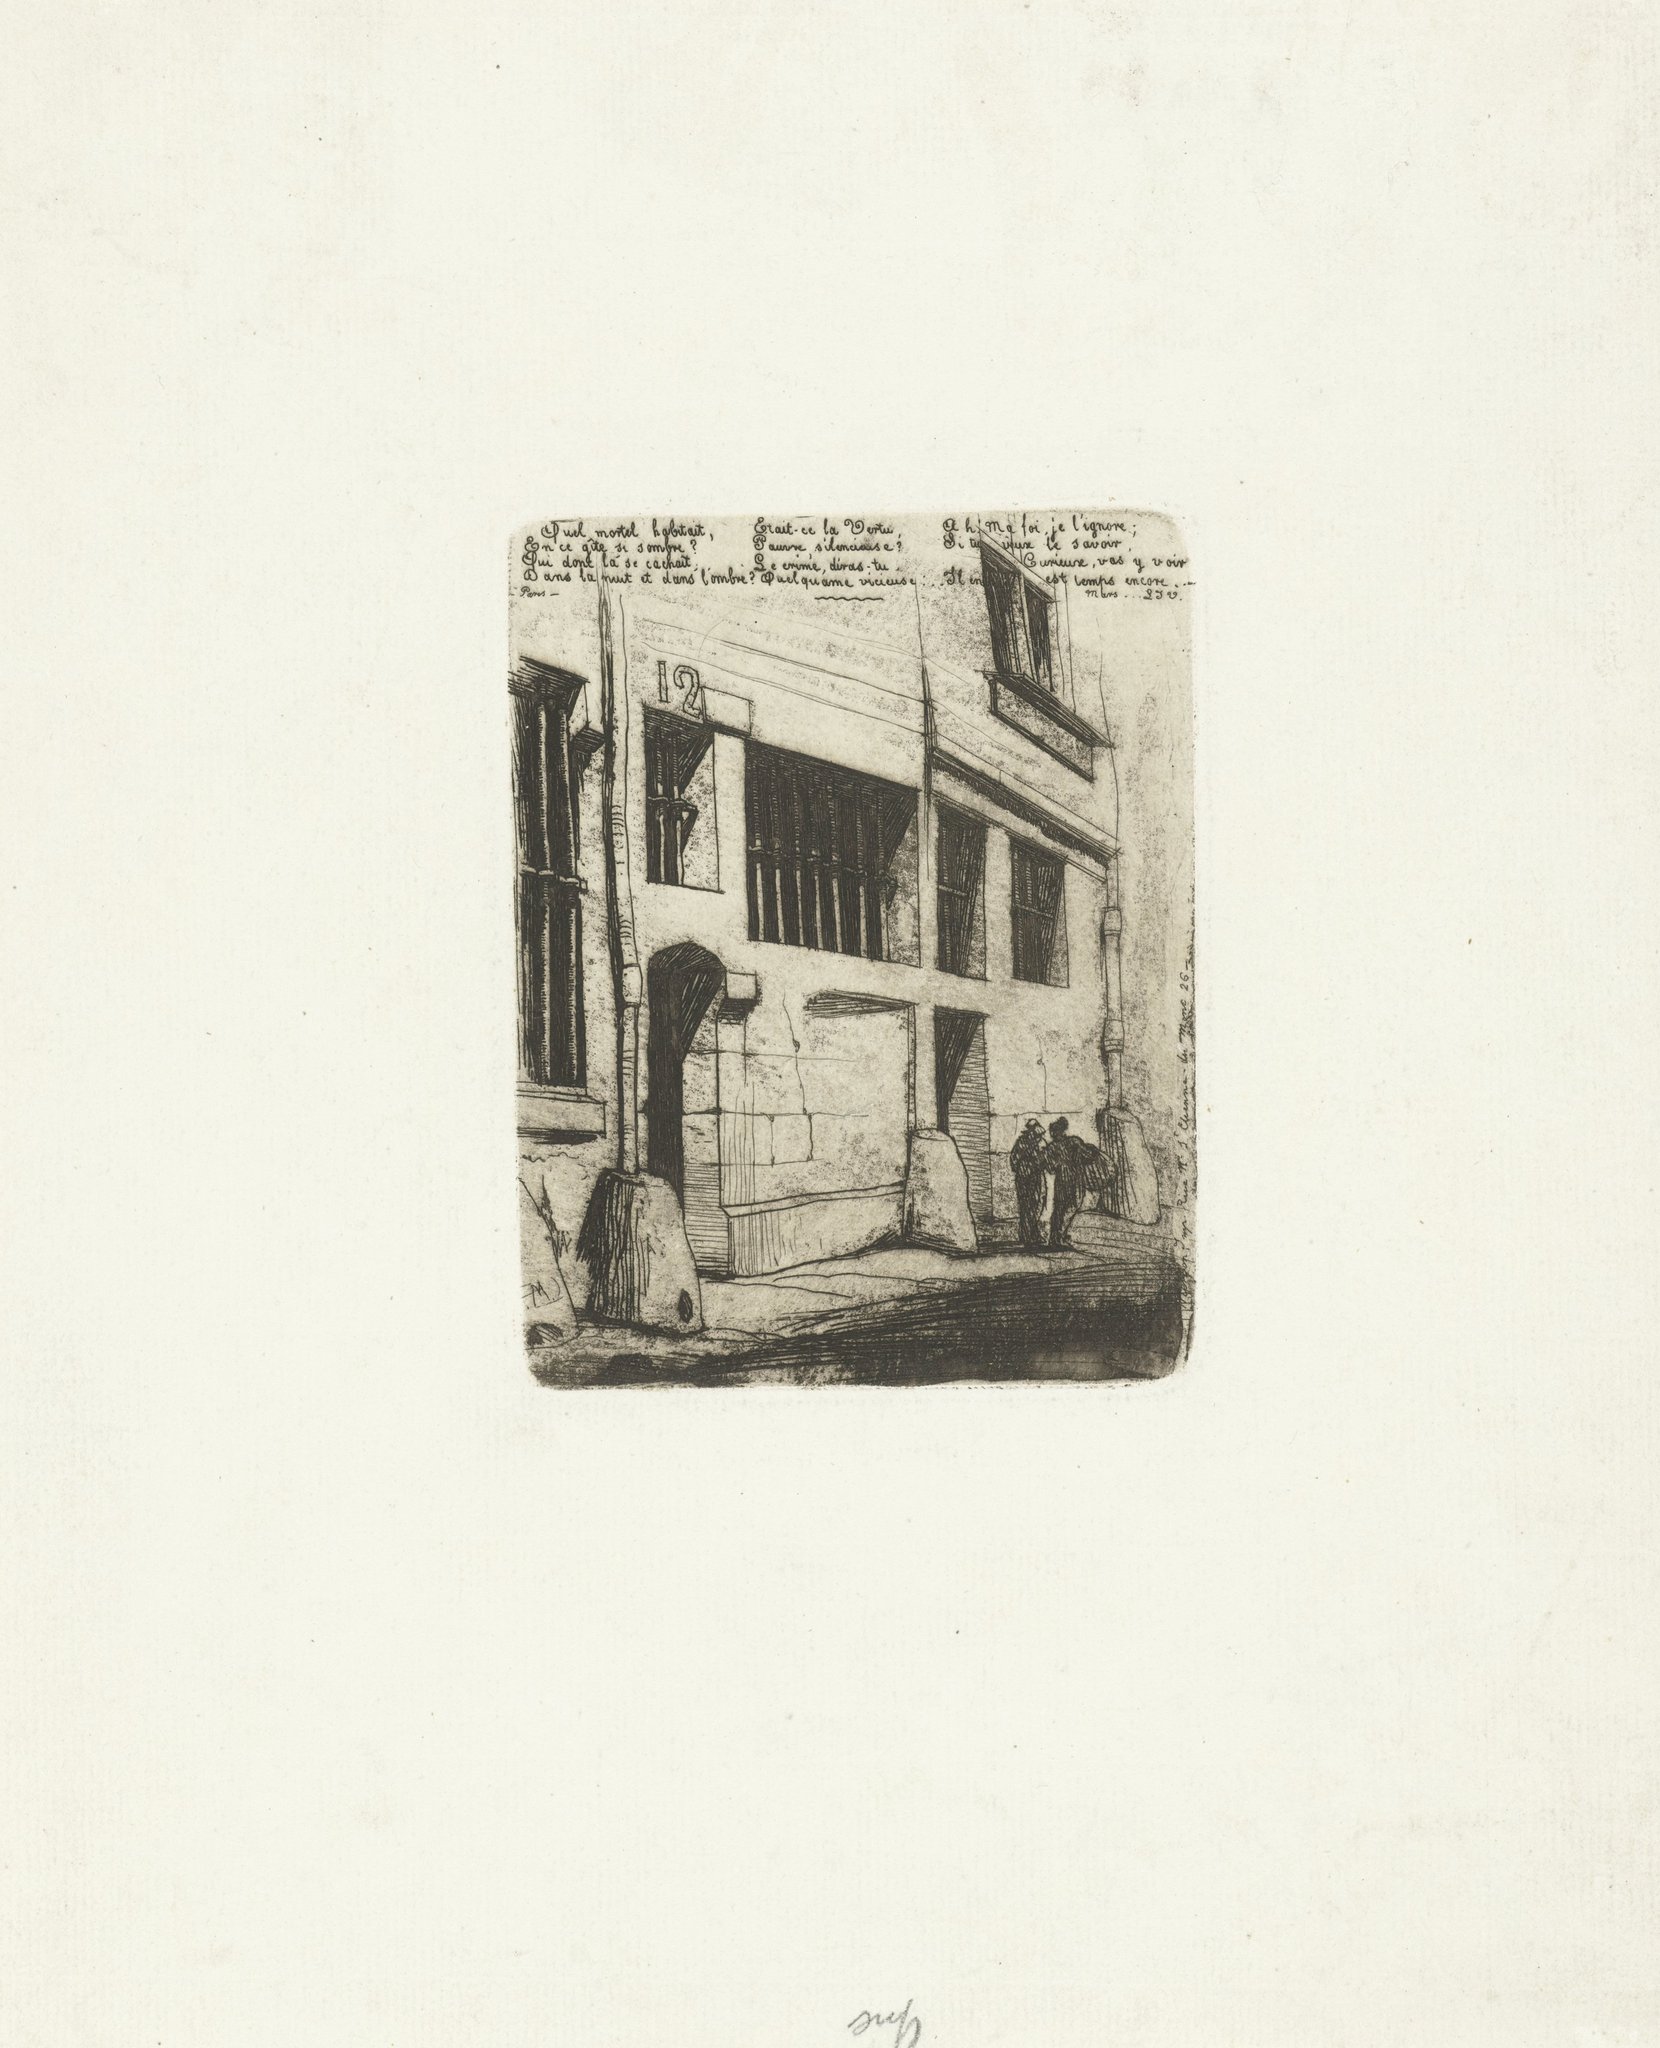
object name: print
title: La Rue des mauvais Garcons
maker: charles meryon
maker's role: print maker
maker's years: 1821-1868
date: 1854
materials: paper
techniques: etching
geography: france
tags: brothel, street, paris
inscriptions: collector's mark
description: Dit oude bordeel in de Rue des mauvais Garcons in Parijs werd in 1851 afgebroken. Opvallend is het schetsmatige karakter van de voorstelling dat we ook bij de voorstudie terugzien. Er zijn weinig details uitgewerkt en de voorstelling lijkt vooral te bestaan uit lichte en donkere vlakken. Het gedicht dat in drie coupletten boven de voorstelling staat gaat over de gang van zaken in deze straat waar mannen een bezoek brachten aan het bordeel.